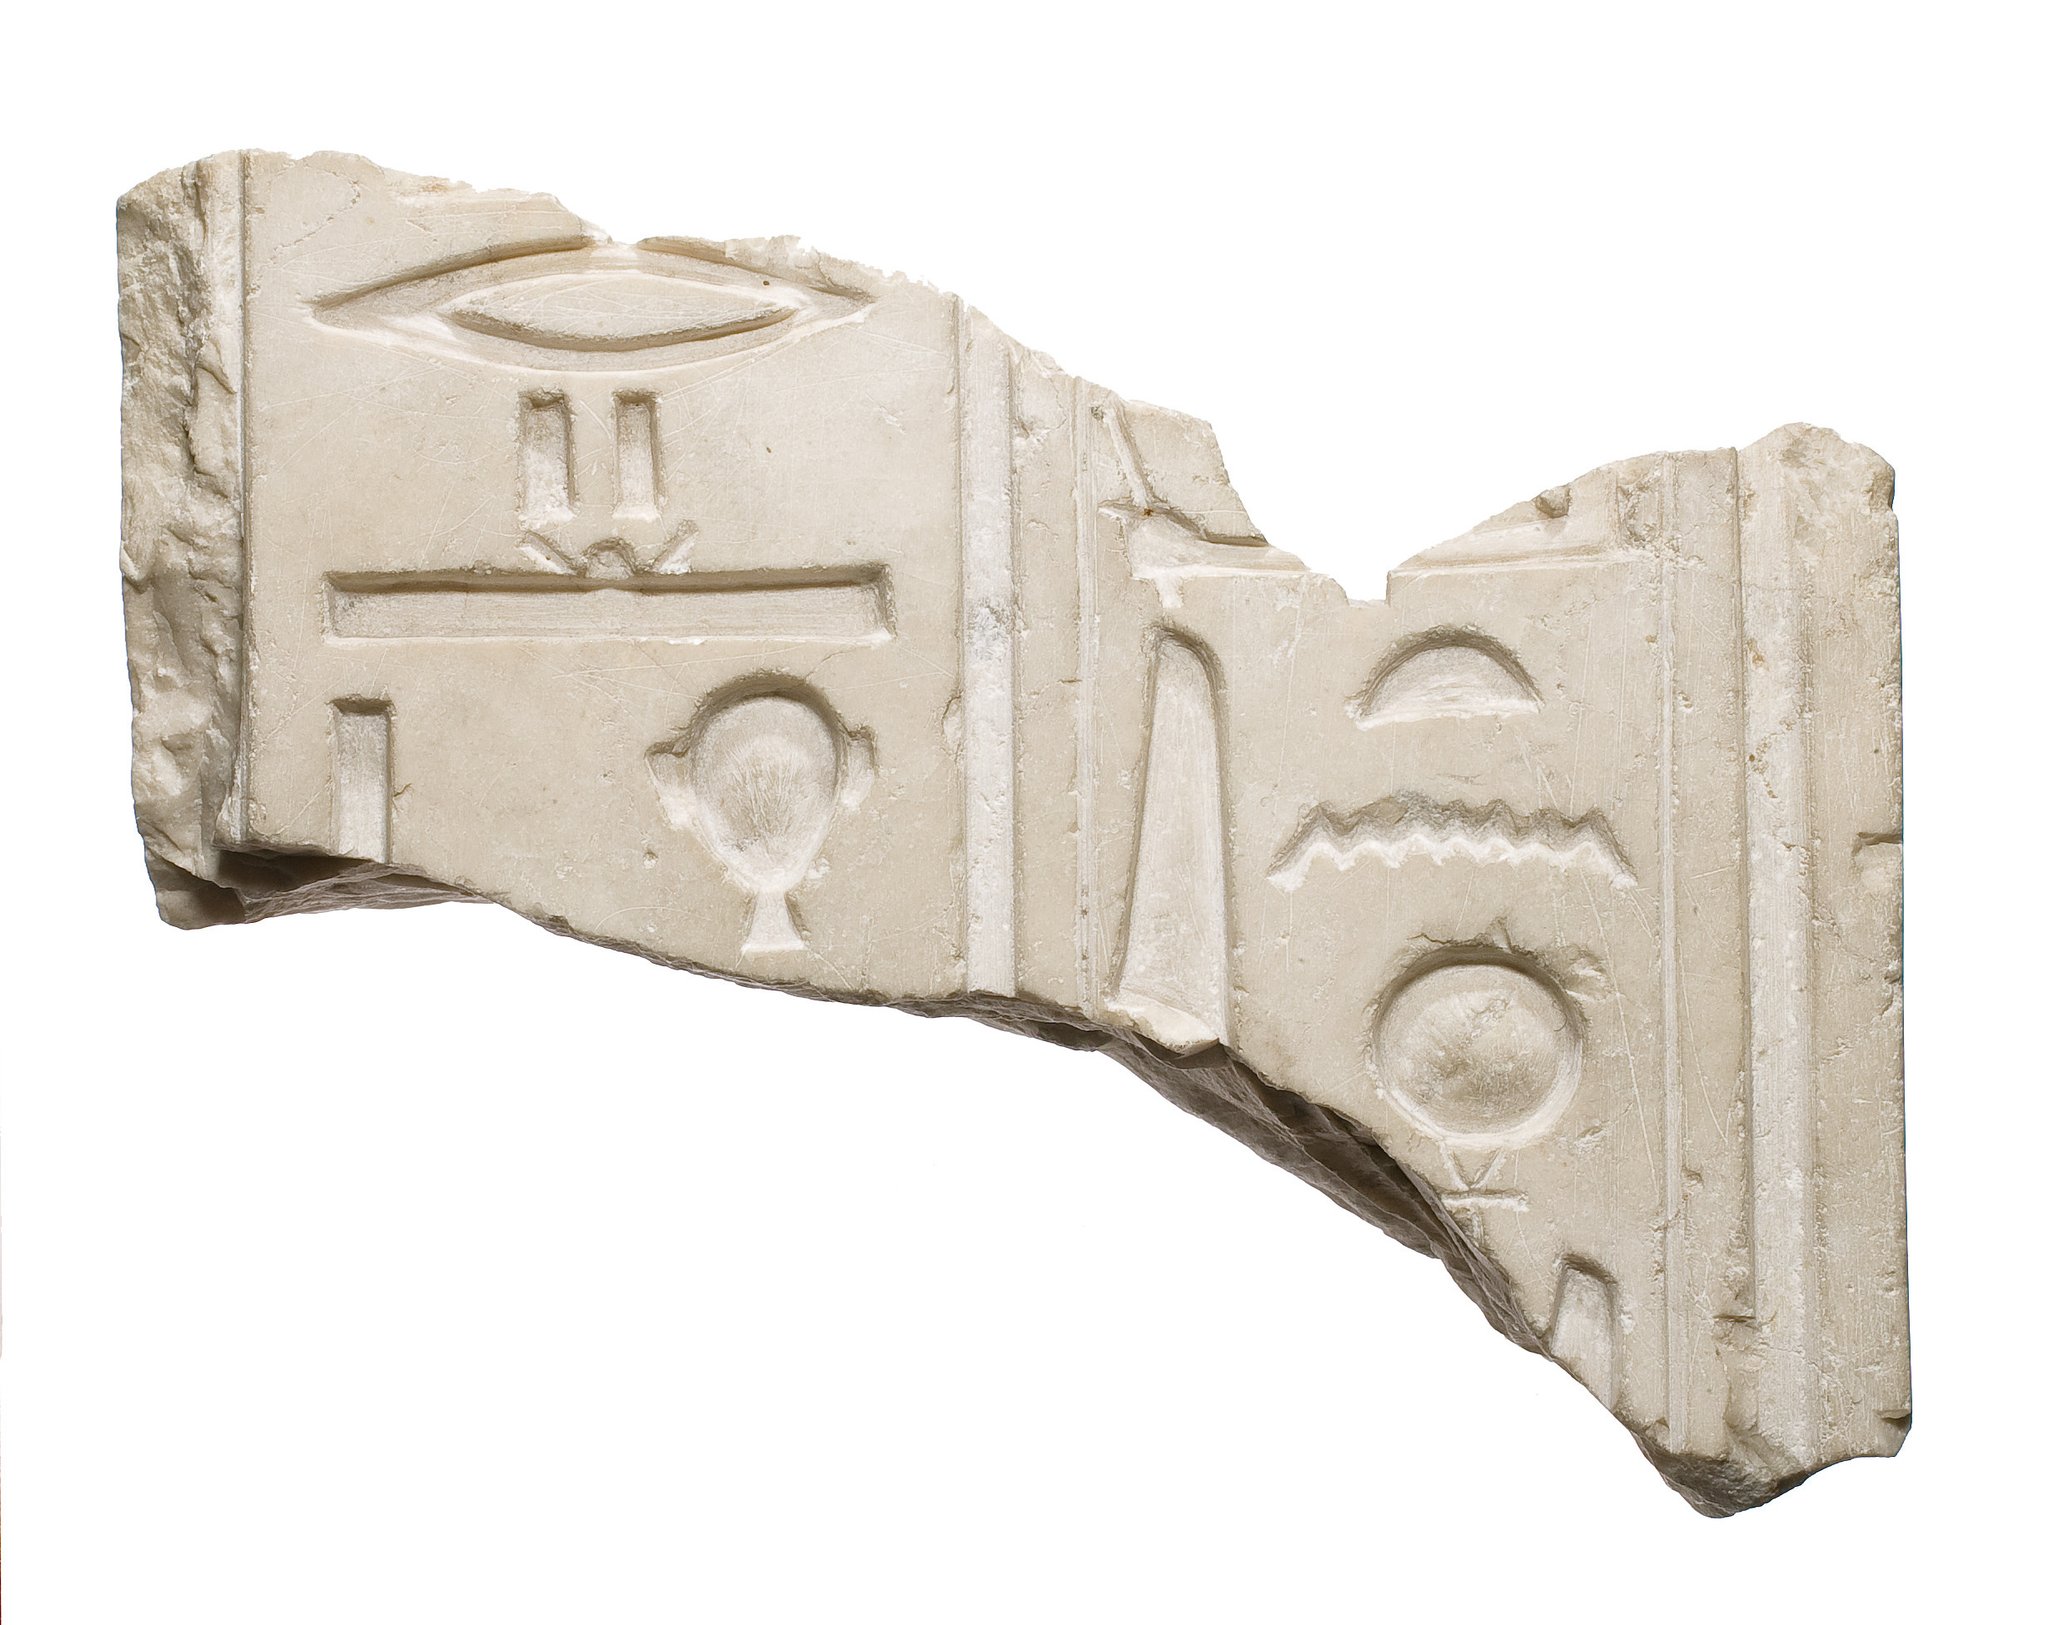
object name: pillar fragment, aten and akhenaten named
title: Pillar perhaps attached to statue, name of Akhenaten, epithets of Aten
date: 1353-1336 BCE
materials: limestone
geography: egypt